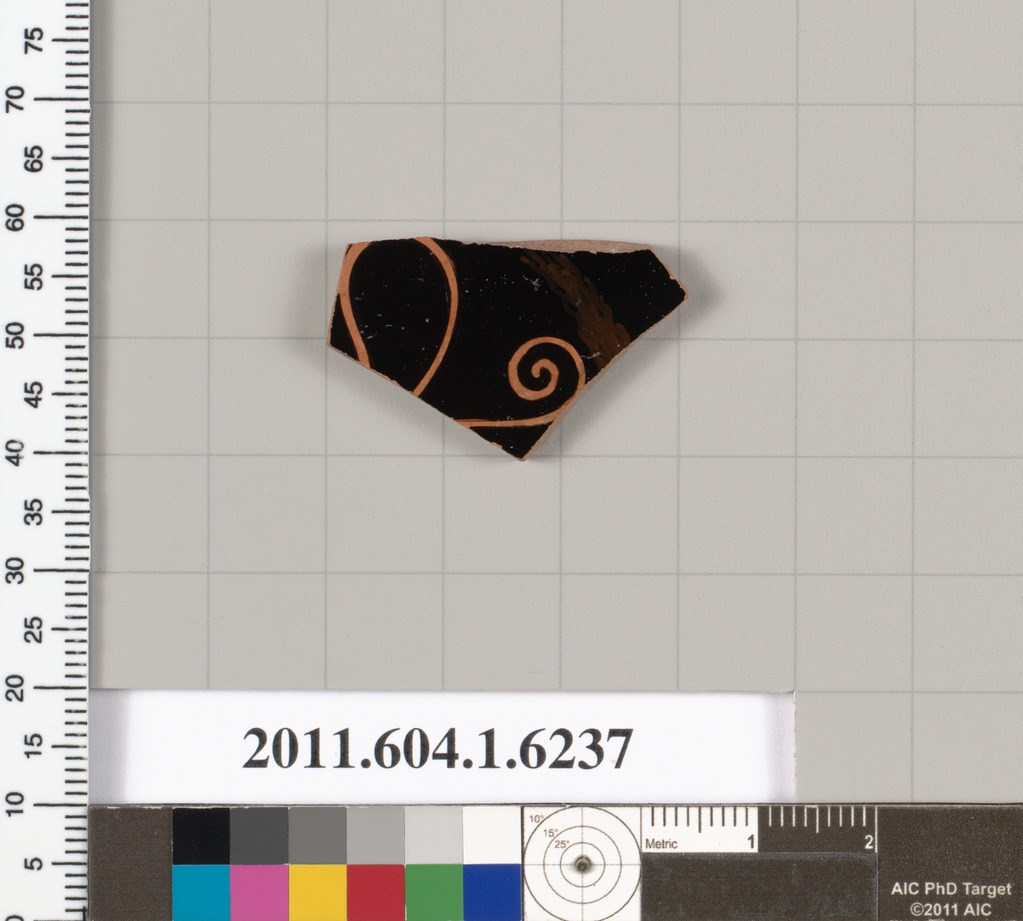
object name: kylix fragment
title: Terracotta fragment of a kylix (drinking cup)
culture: greek, attic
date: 520-510 BCE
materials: terracotta